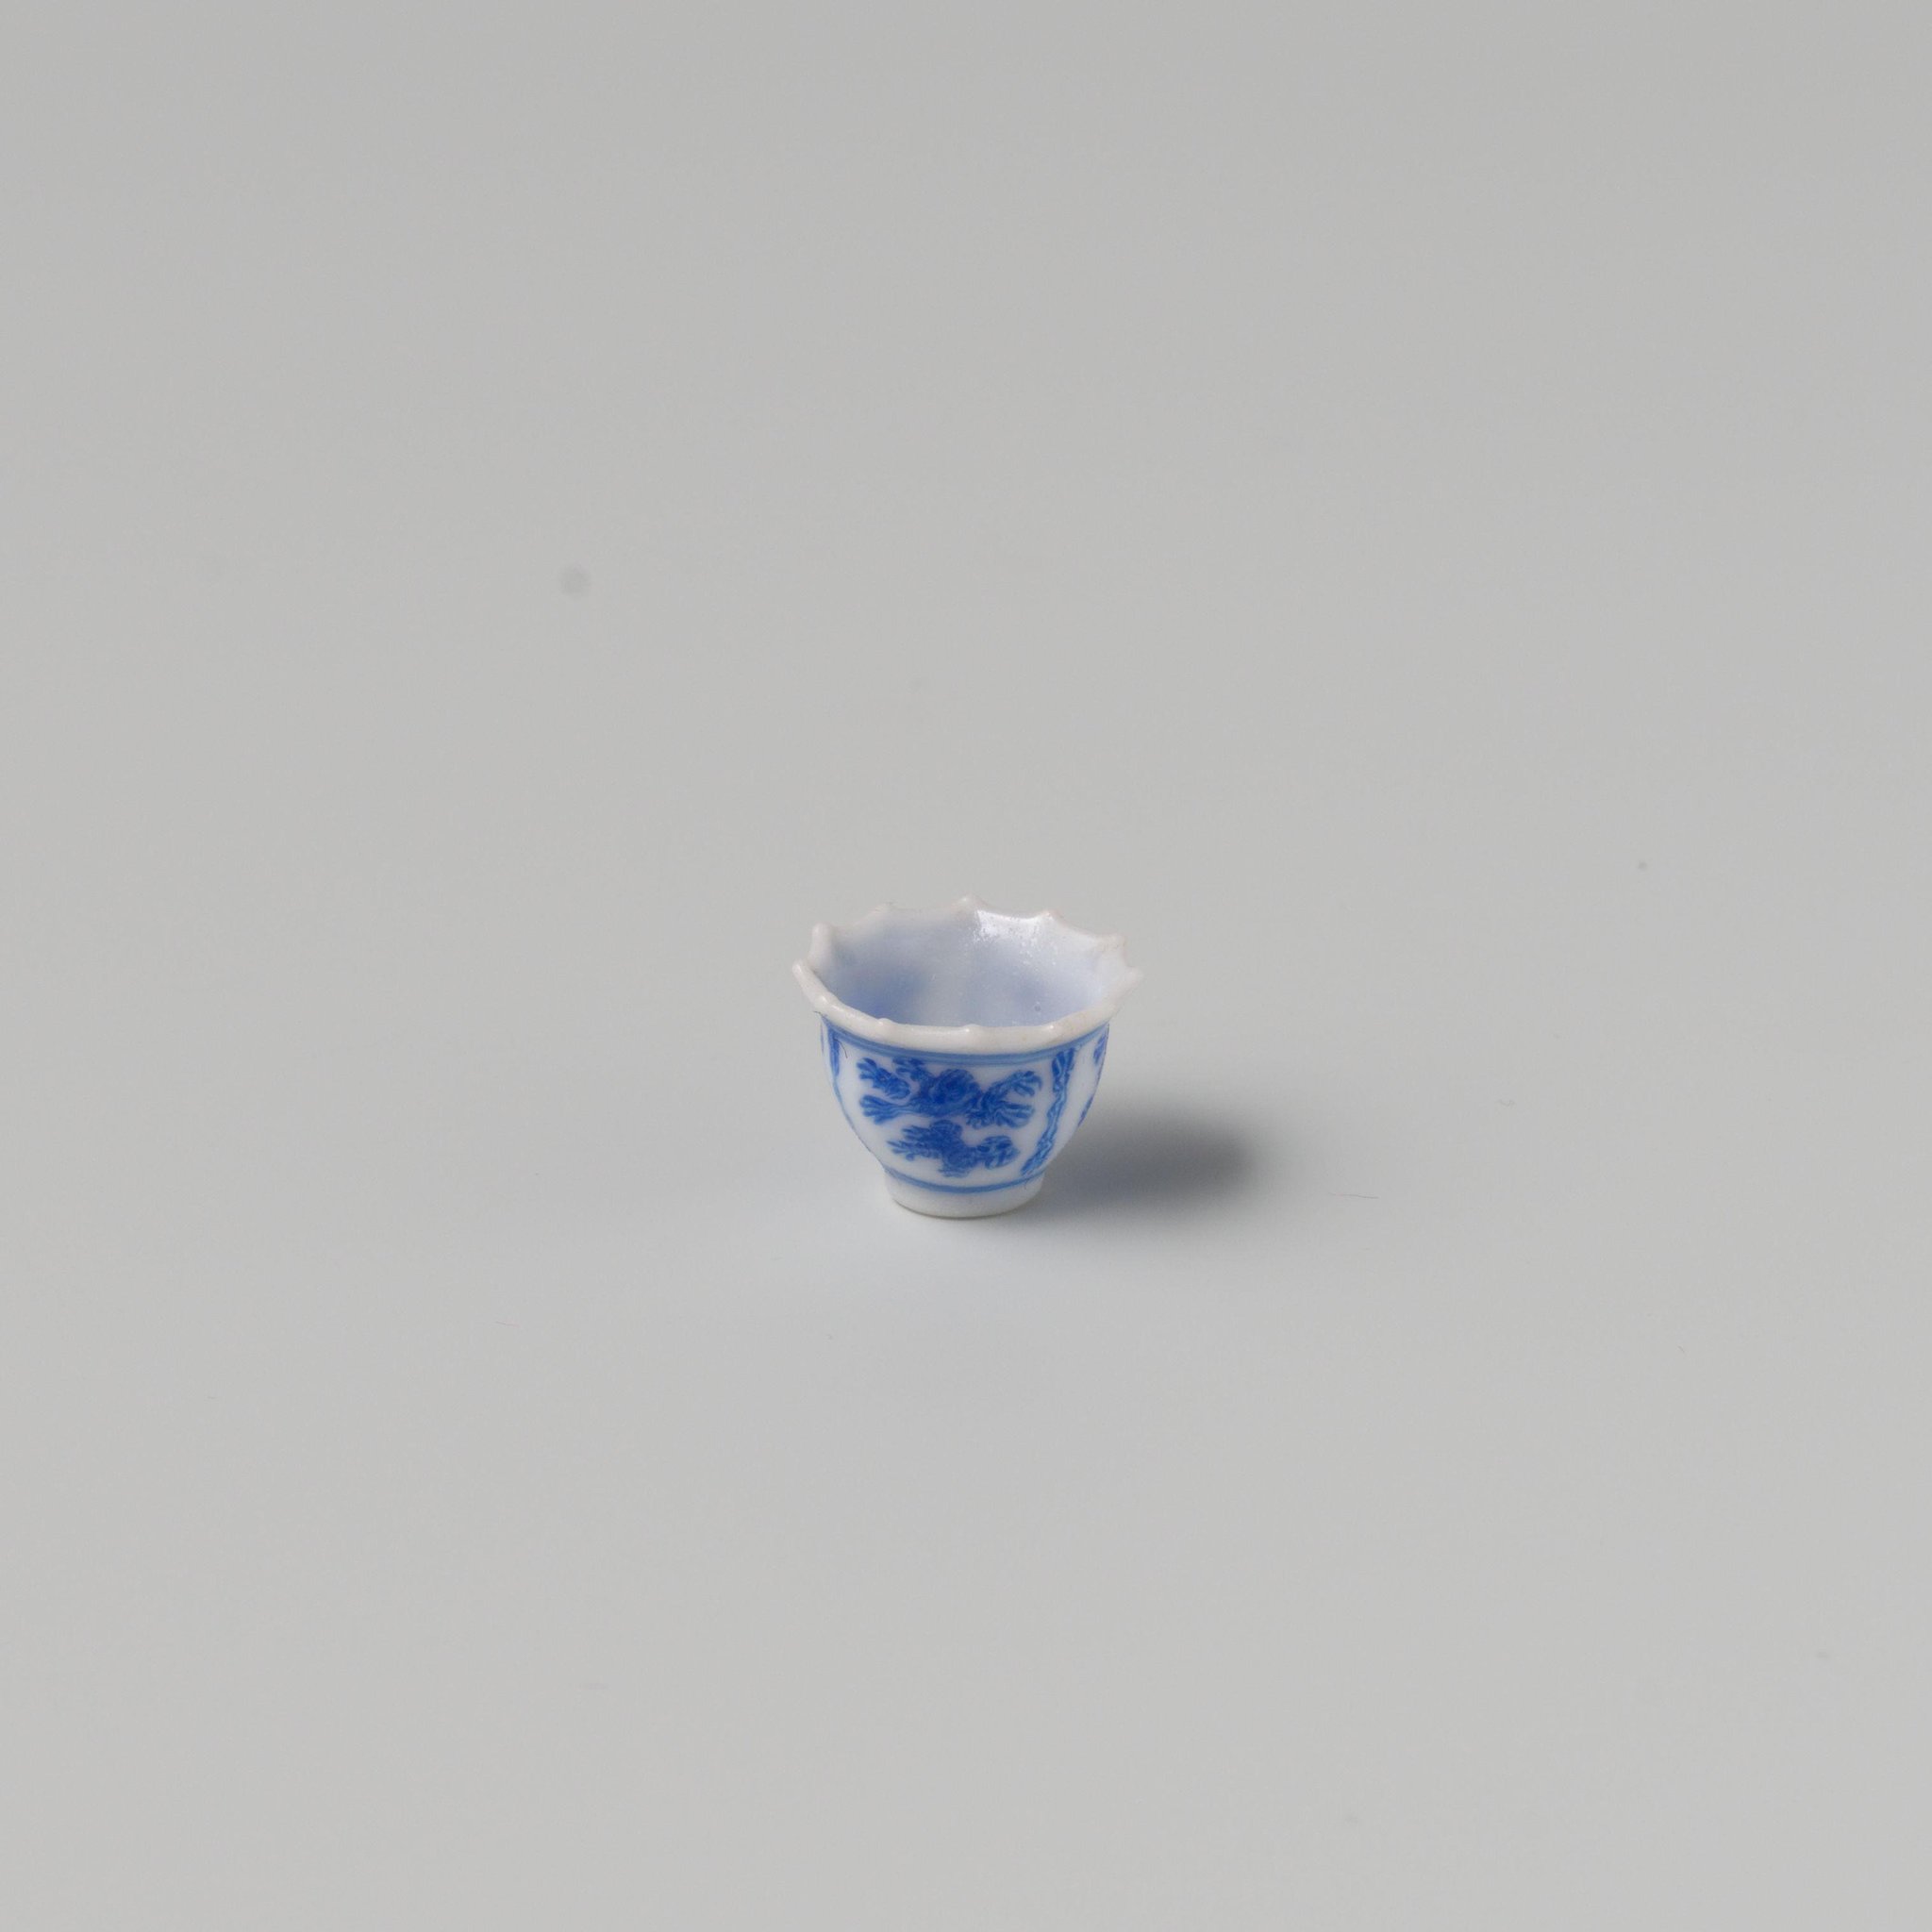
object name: tea cup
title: Theekopje van melkglas met blauwe emailverf beschildering, imitatie Chinees porselein met 'bloem' decoratie in drie vakken; model met puntrand, nauwelijks een standring.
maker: Anonymous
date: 1675-1710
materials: glass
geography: amsterdam